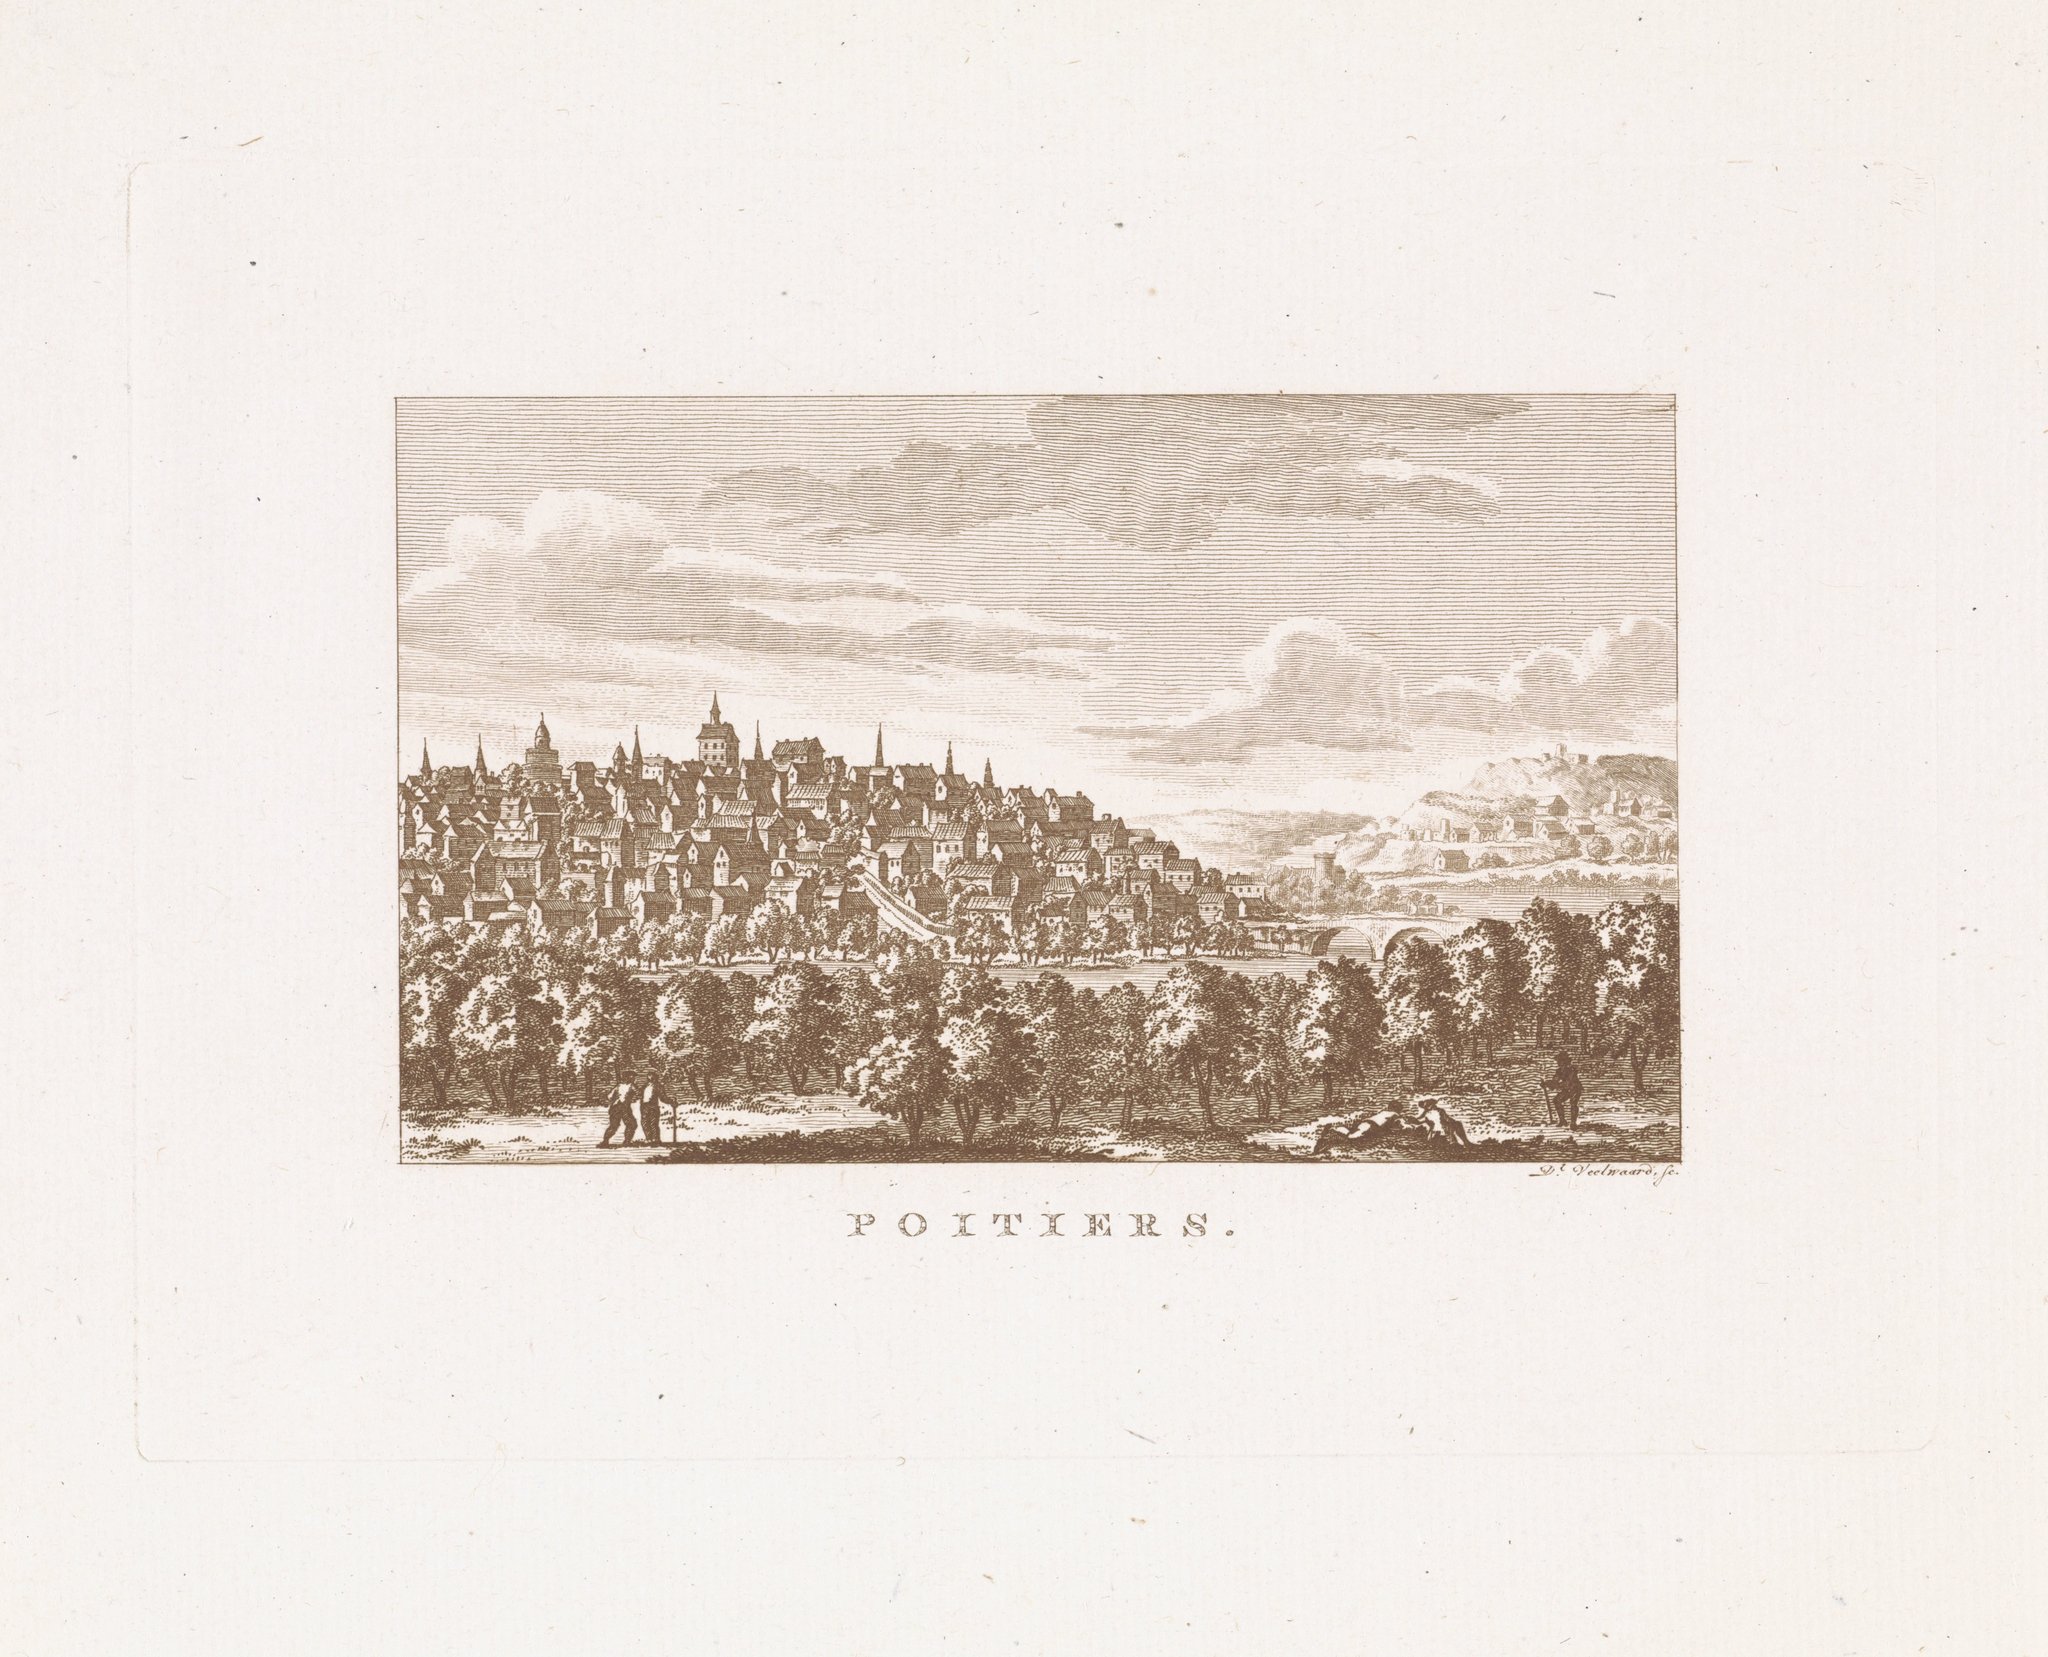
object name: print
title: Gezicht op Poitiers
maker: daniël veelwaard (i)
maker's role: print maker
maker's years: 1766-1851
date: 1776-1851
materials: paper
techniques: etching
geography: amsterdam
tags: prospect of city, town panorama, silhouette of city (+ city(-scape) with figures, staffage)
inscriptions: collector's mark: Lugt 2228